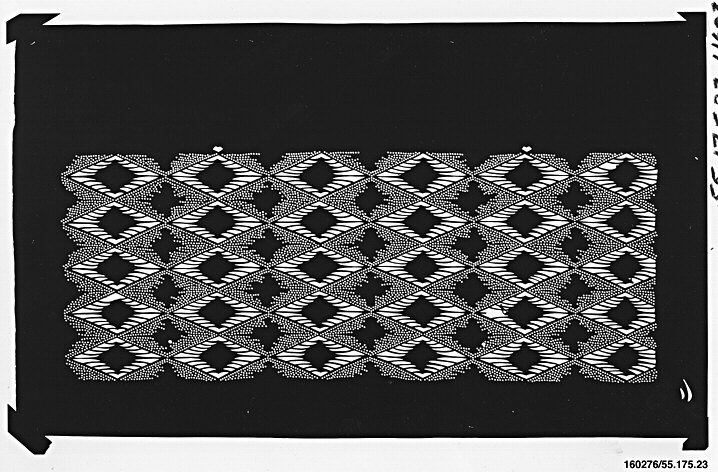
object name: stencil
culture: japanese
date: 1801-1900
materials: paper